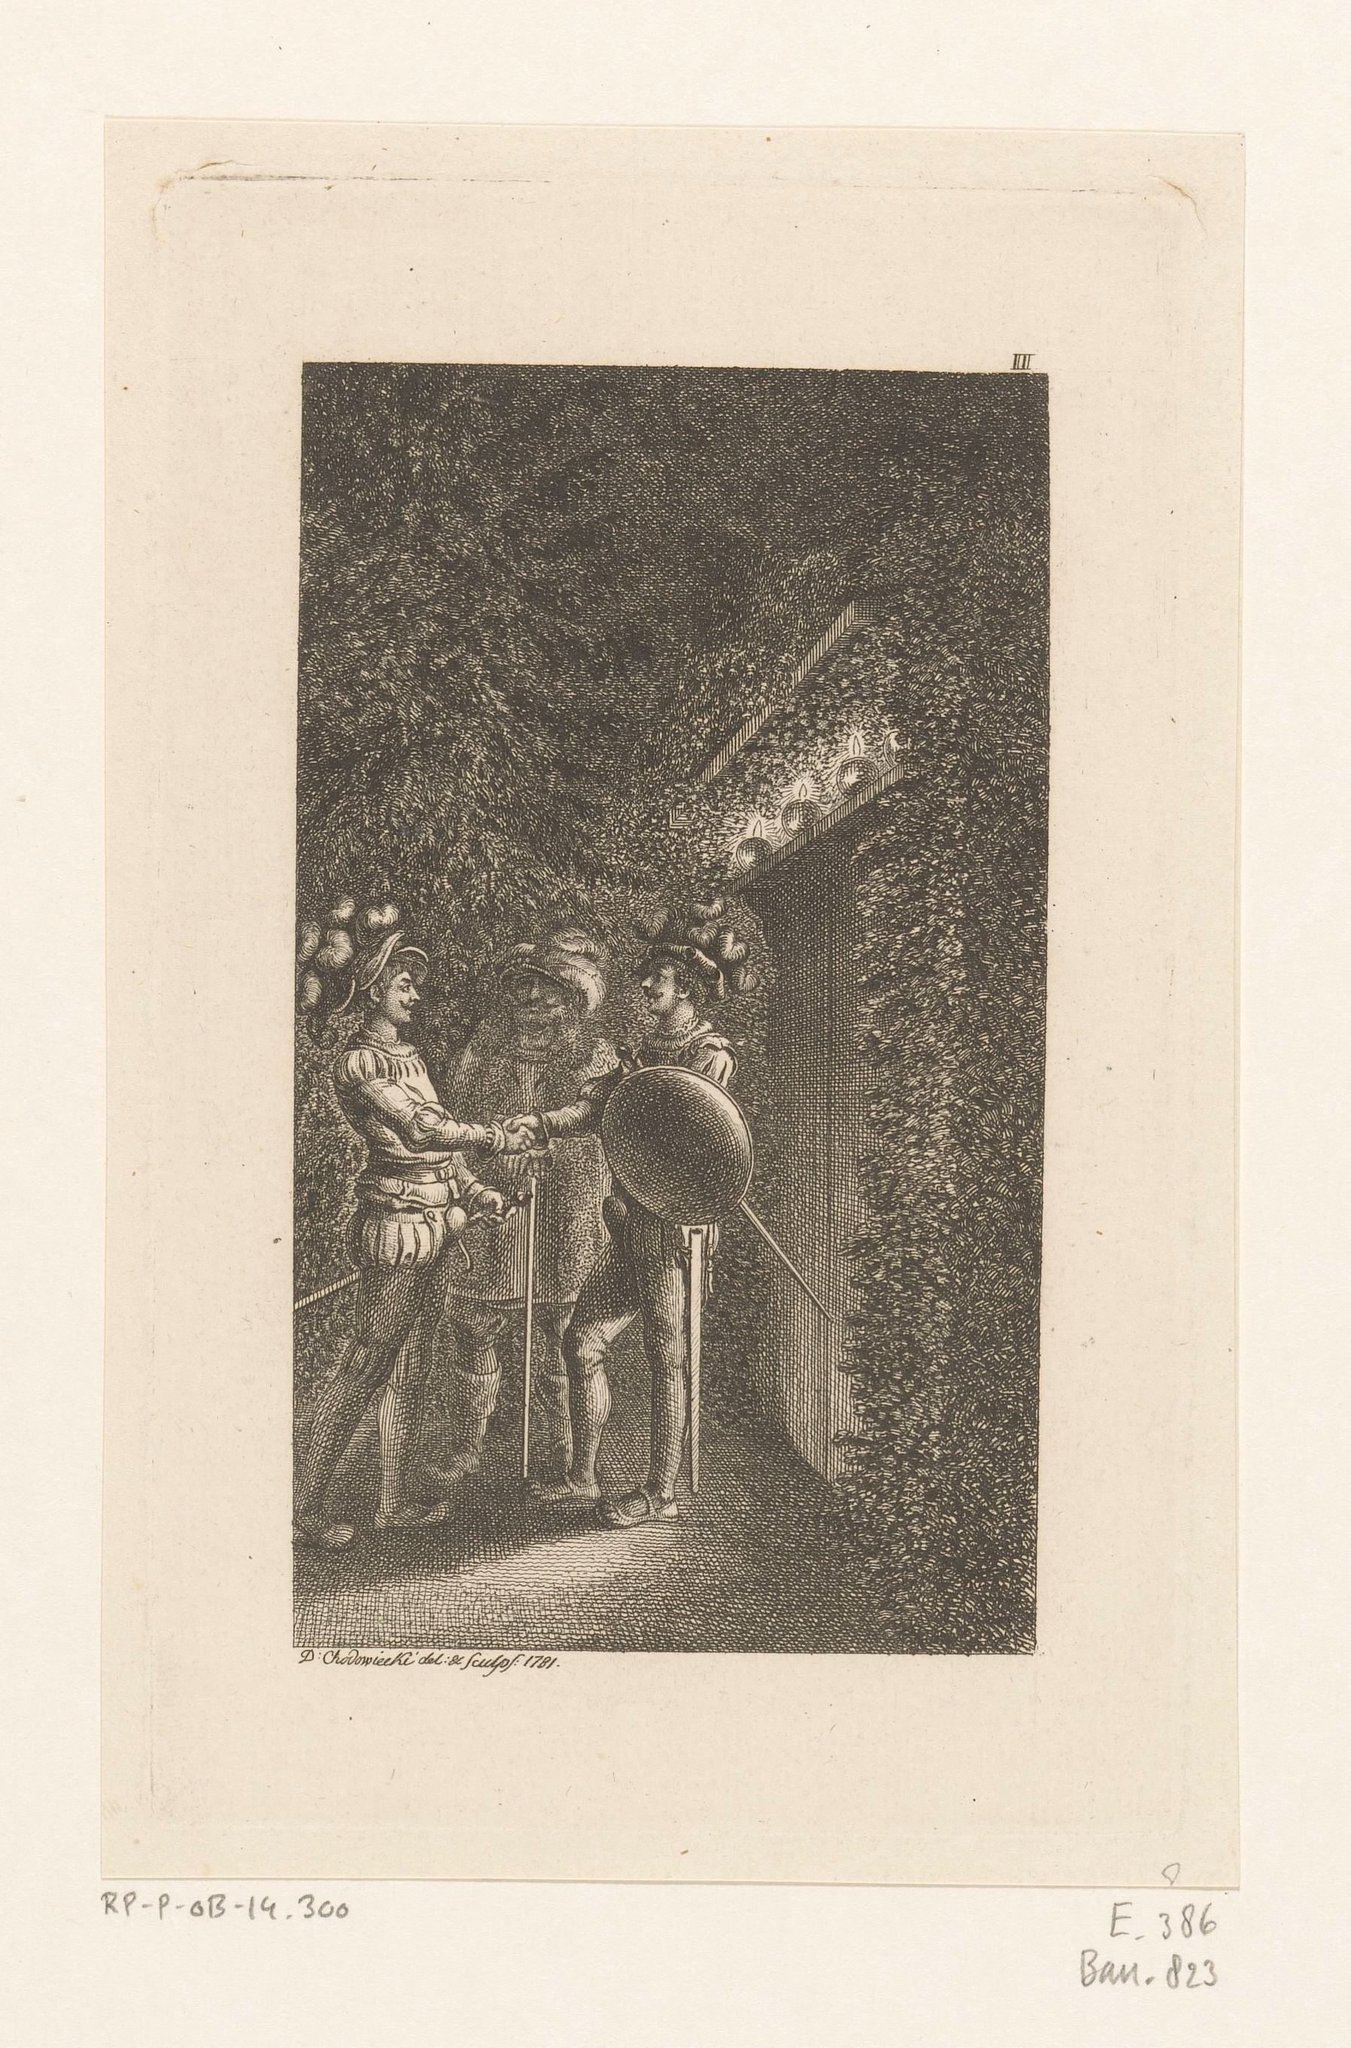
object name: print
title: Gevar, Hialte en Hother plotten de moord op Rolf Krage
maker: daniel nikolaus chodowiecki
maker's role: draughtsman, print maker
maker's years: 1726-1801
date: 1781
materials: paper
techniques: etching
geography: berlin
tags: copenhagen (city), (revolutionary) plot, conspiracy, shaking hands, 'dextrarum junctio', night, closed door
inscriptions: collector's mark: Lugt 2228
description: Prent gebruikt voor: Ewald, Johannes. Johannes Ewald's samtlige Skrifter. 4 dln. Kopenhagen: Christian Gotlob Proft, 1781-1791.